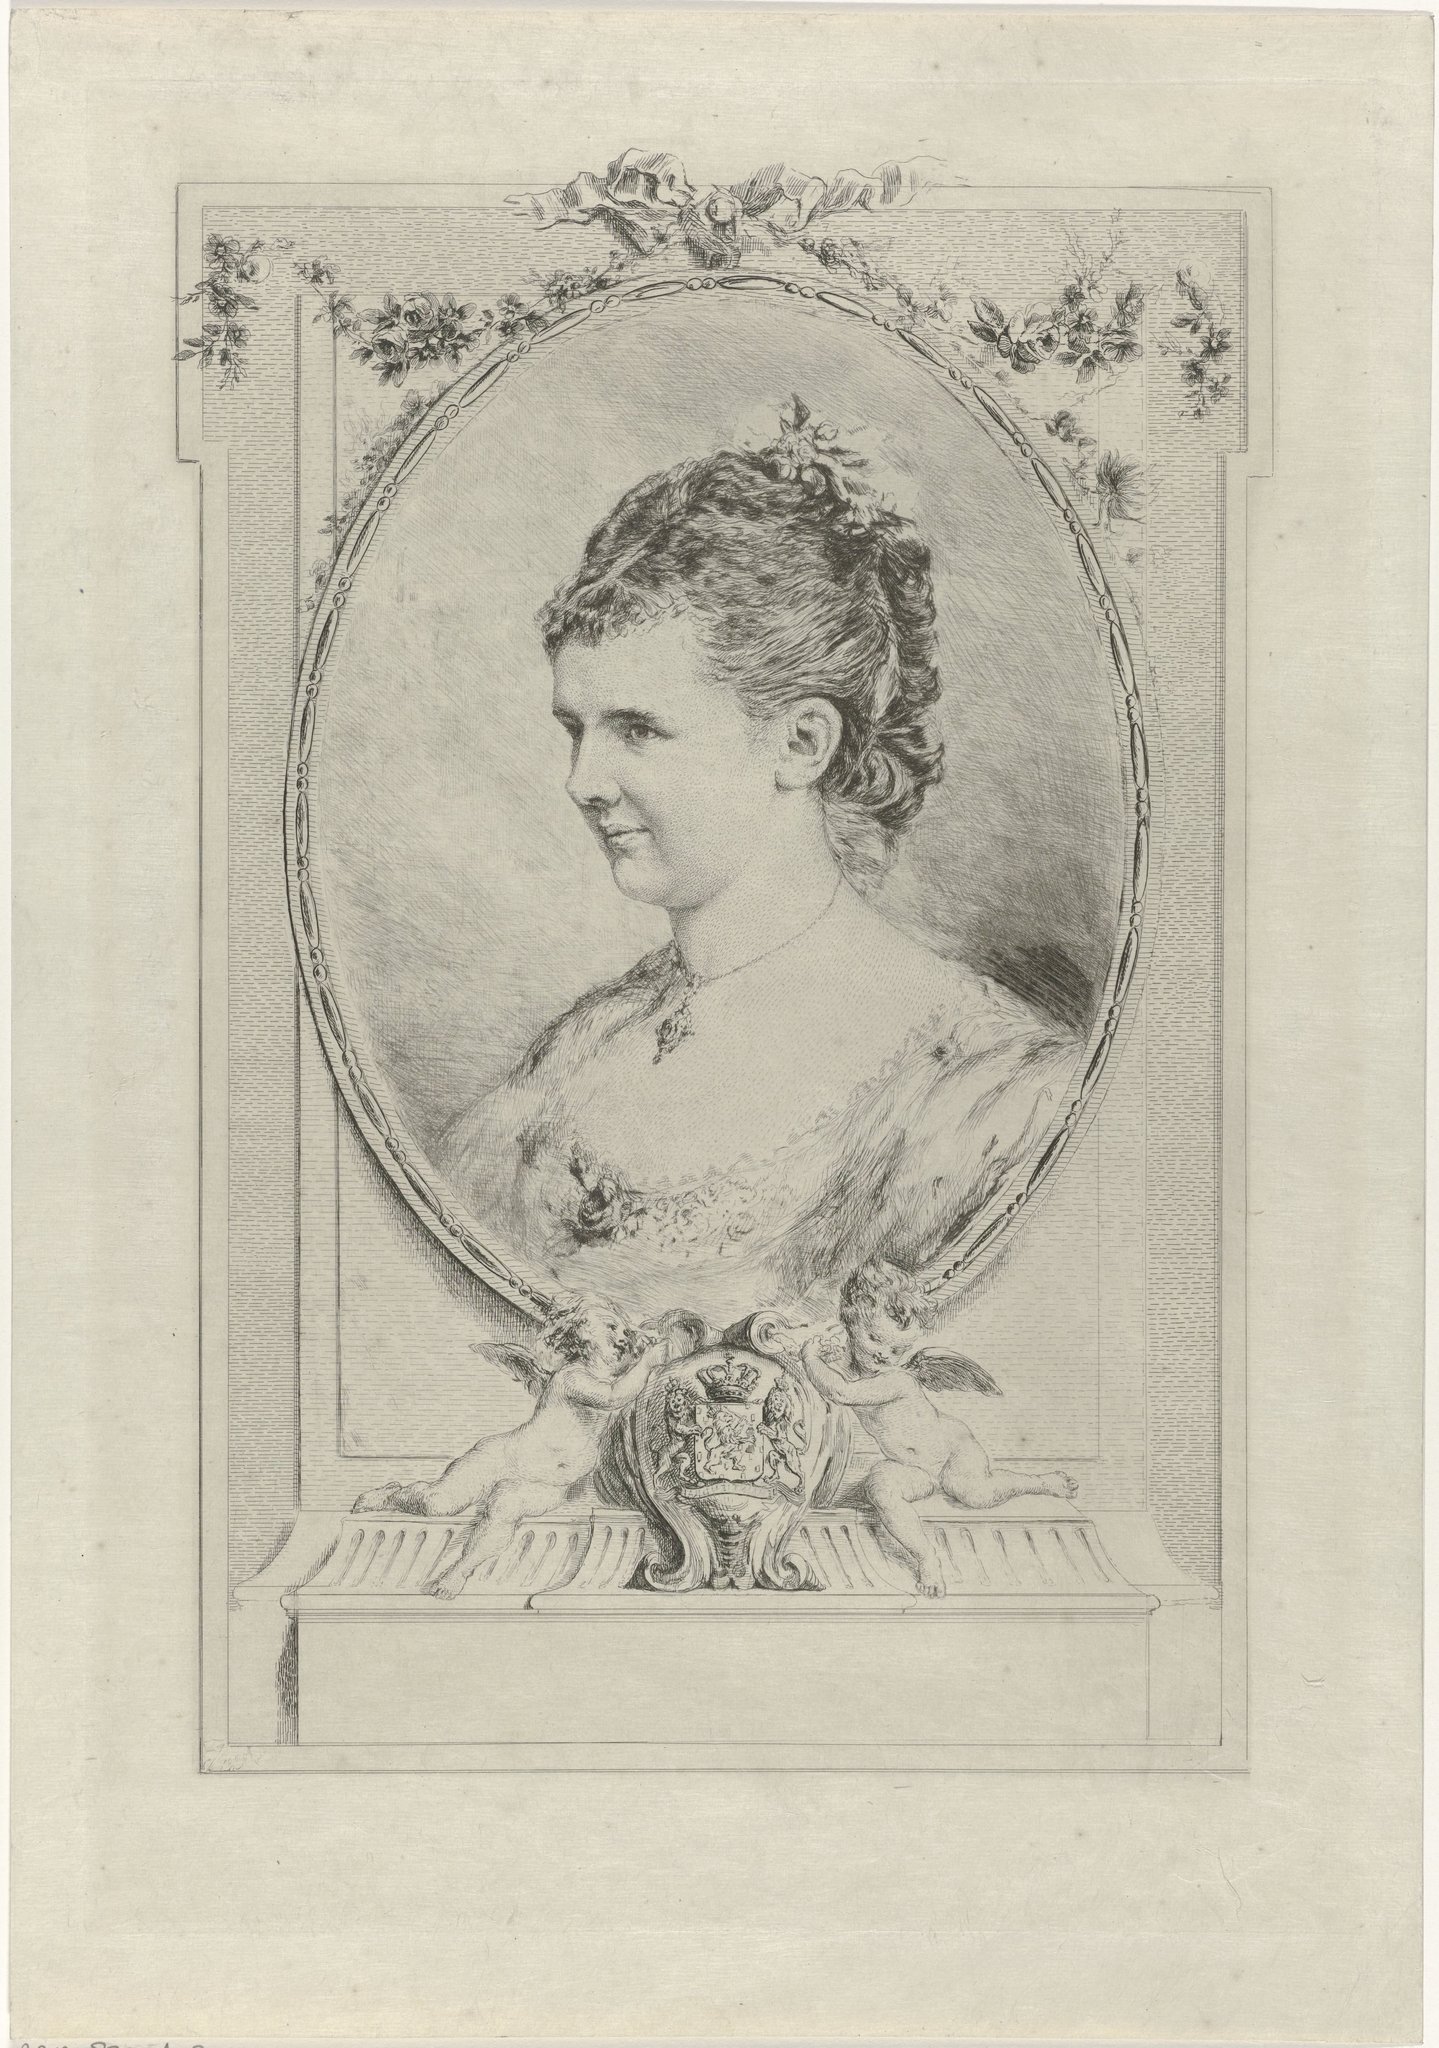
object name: print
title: Portret van Emma, koningin-regentes der Nederlanden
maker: tiburce de mare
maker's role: print maker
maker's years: 1840-1900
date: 1879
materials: paper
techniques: drypoint, etching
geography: belgium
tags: the hague, emma (queen consort of the netherlands)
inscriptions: collector's mark: Lugt 2228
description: De hier vermelde titel verwijst naar de hoogst verkregen titel van de geportretteerde, niet per se naar de titel die de geportretteerde op deze voorstelling draagt.